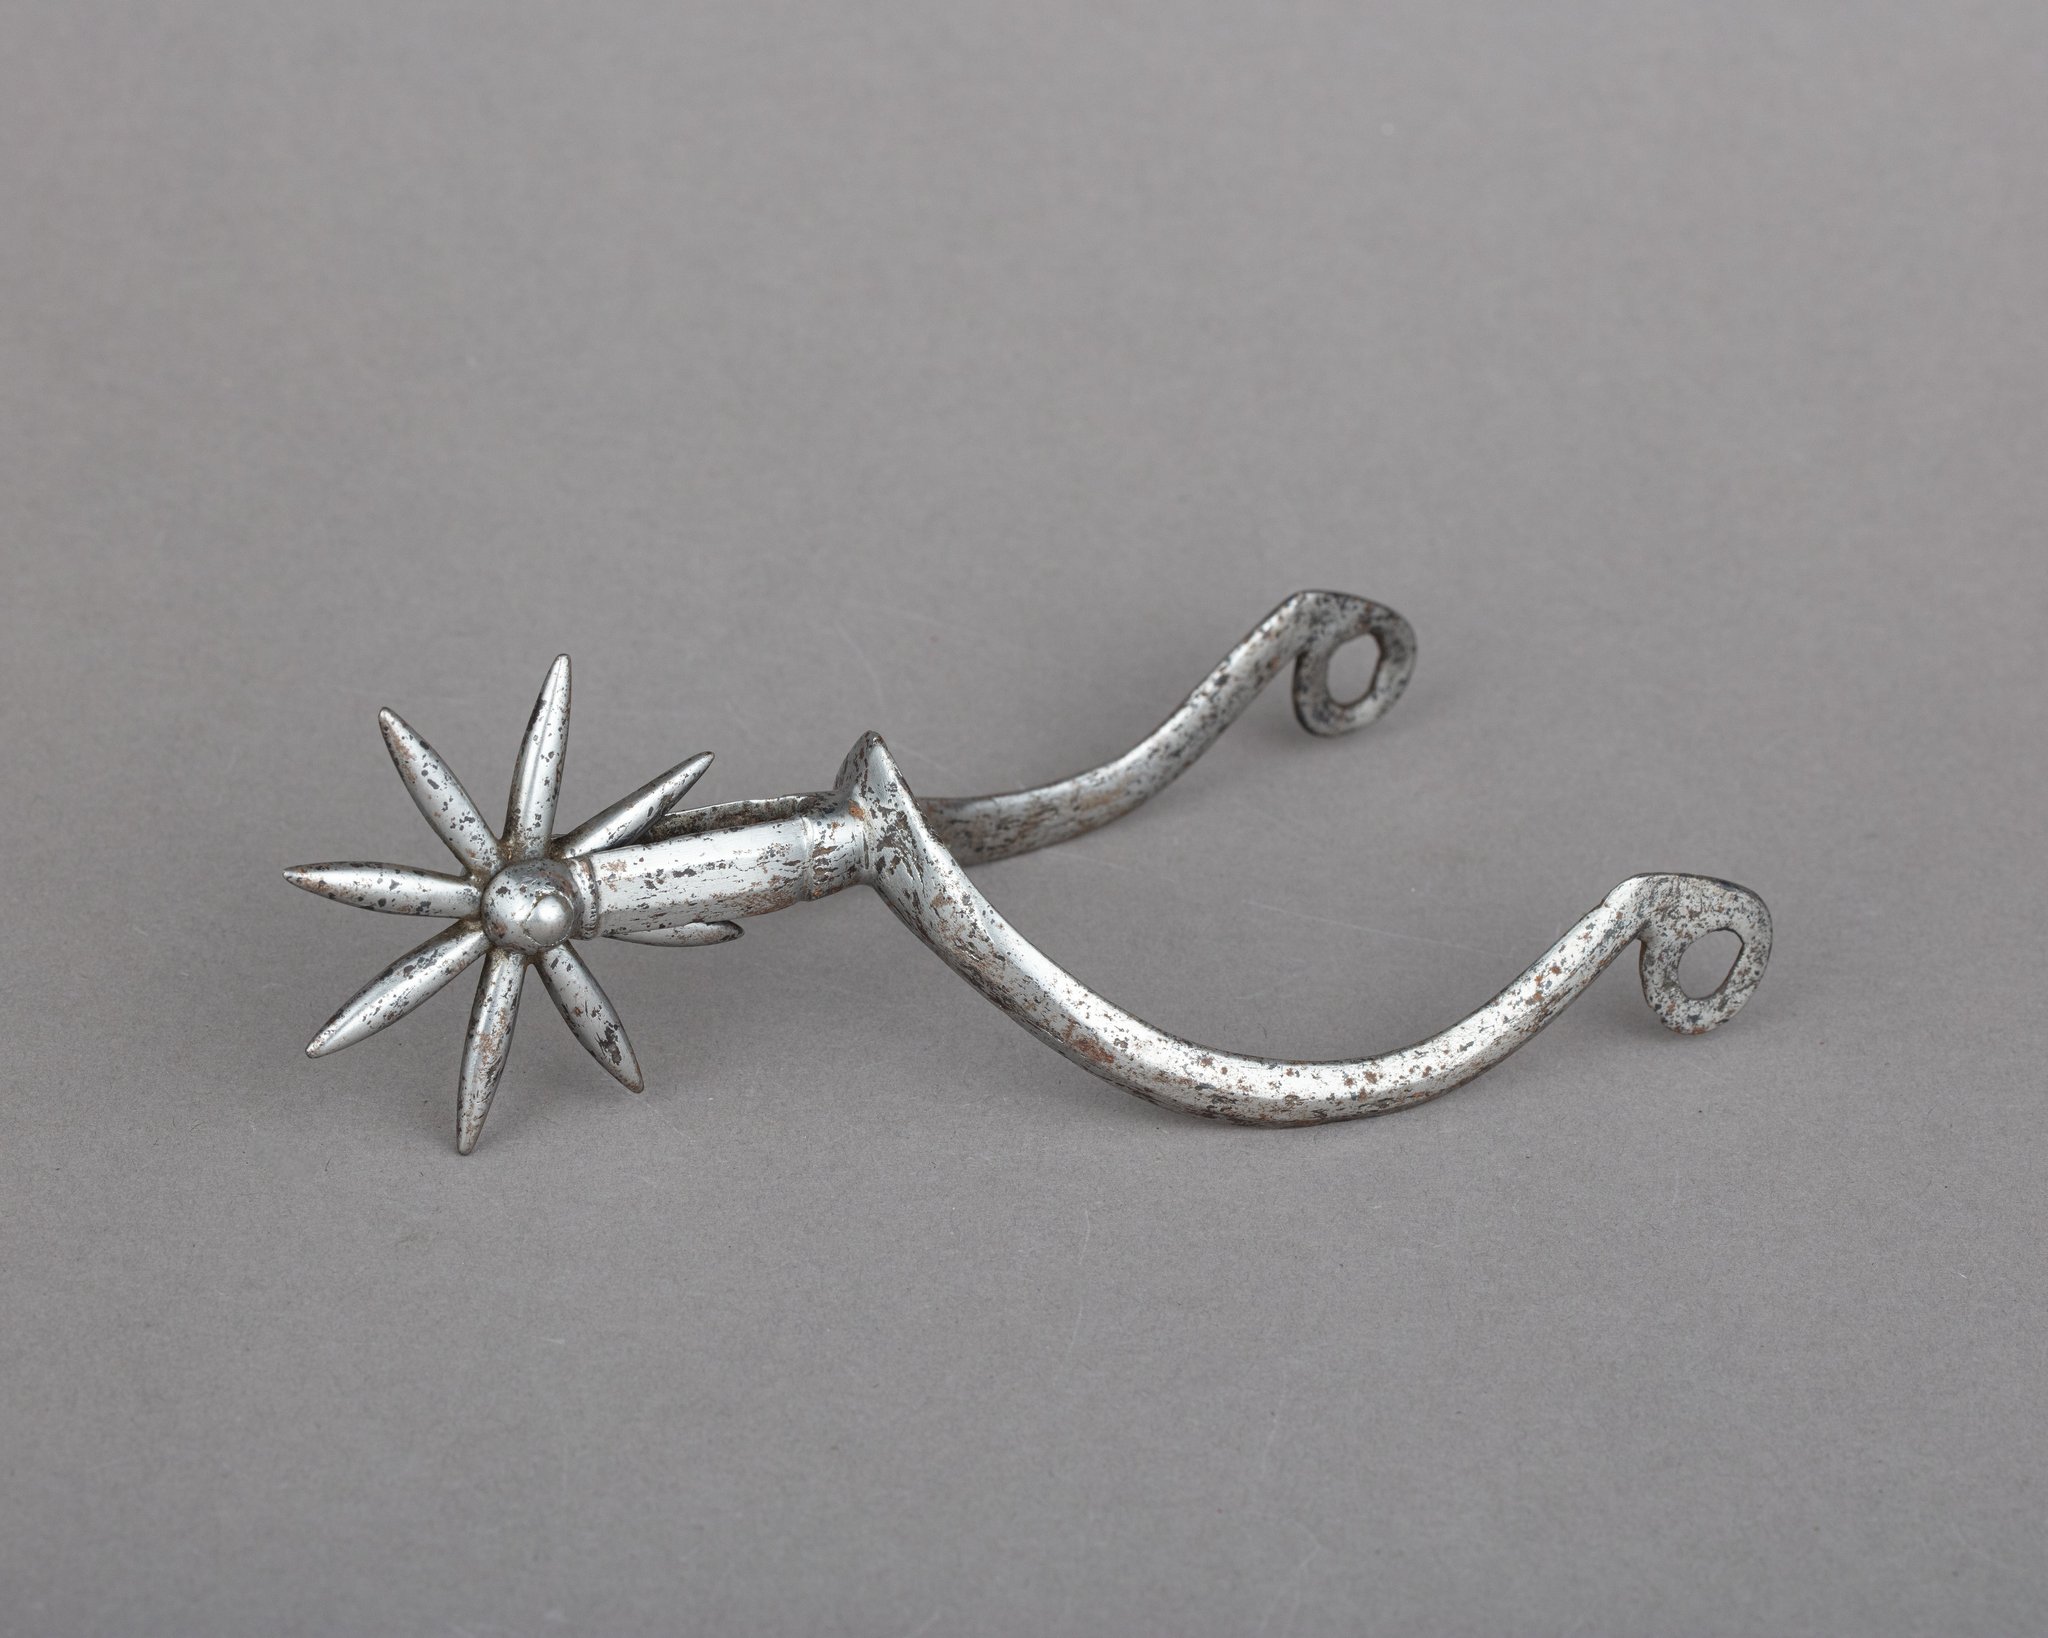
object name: spur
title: Rowel Spur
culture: german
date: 1334-1366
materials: metal alloy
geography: germany